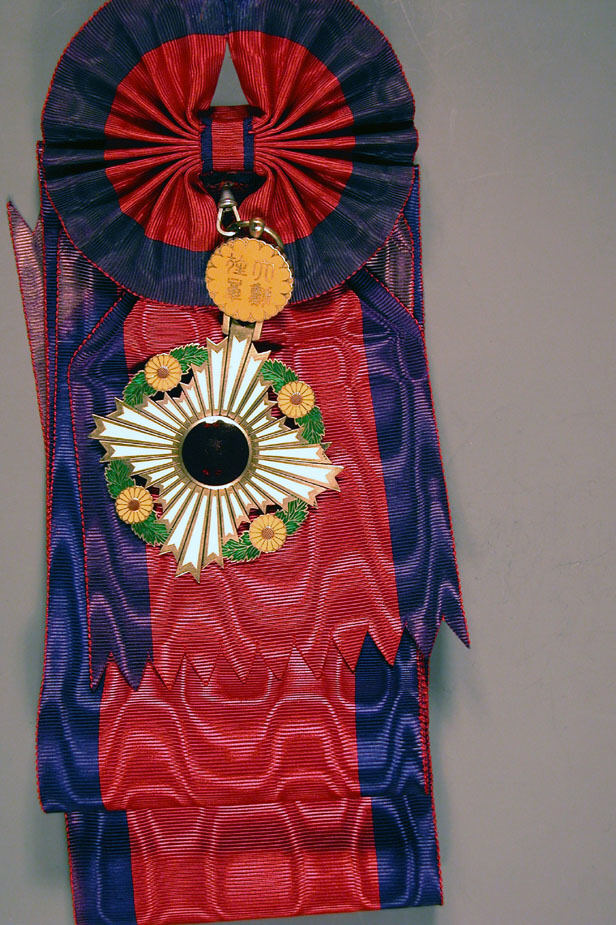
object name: insignia, medal and button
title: Insignia, Medal, Button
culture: japanese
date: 1867-1900